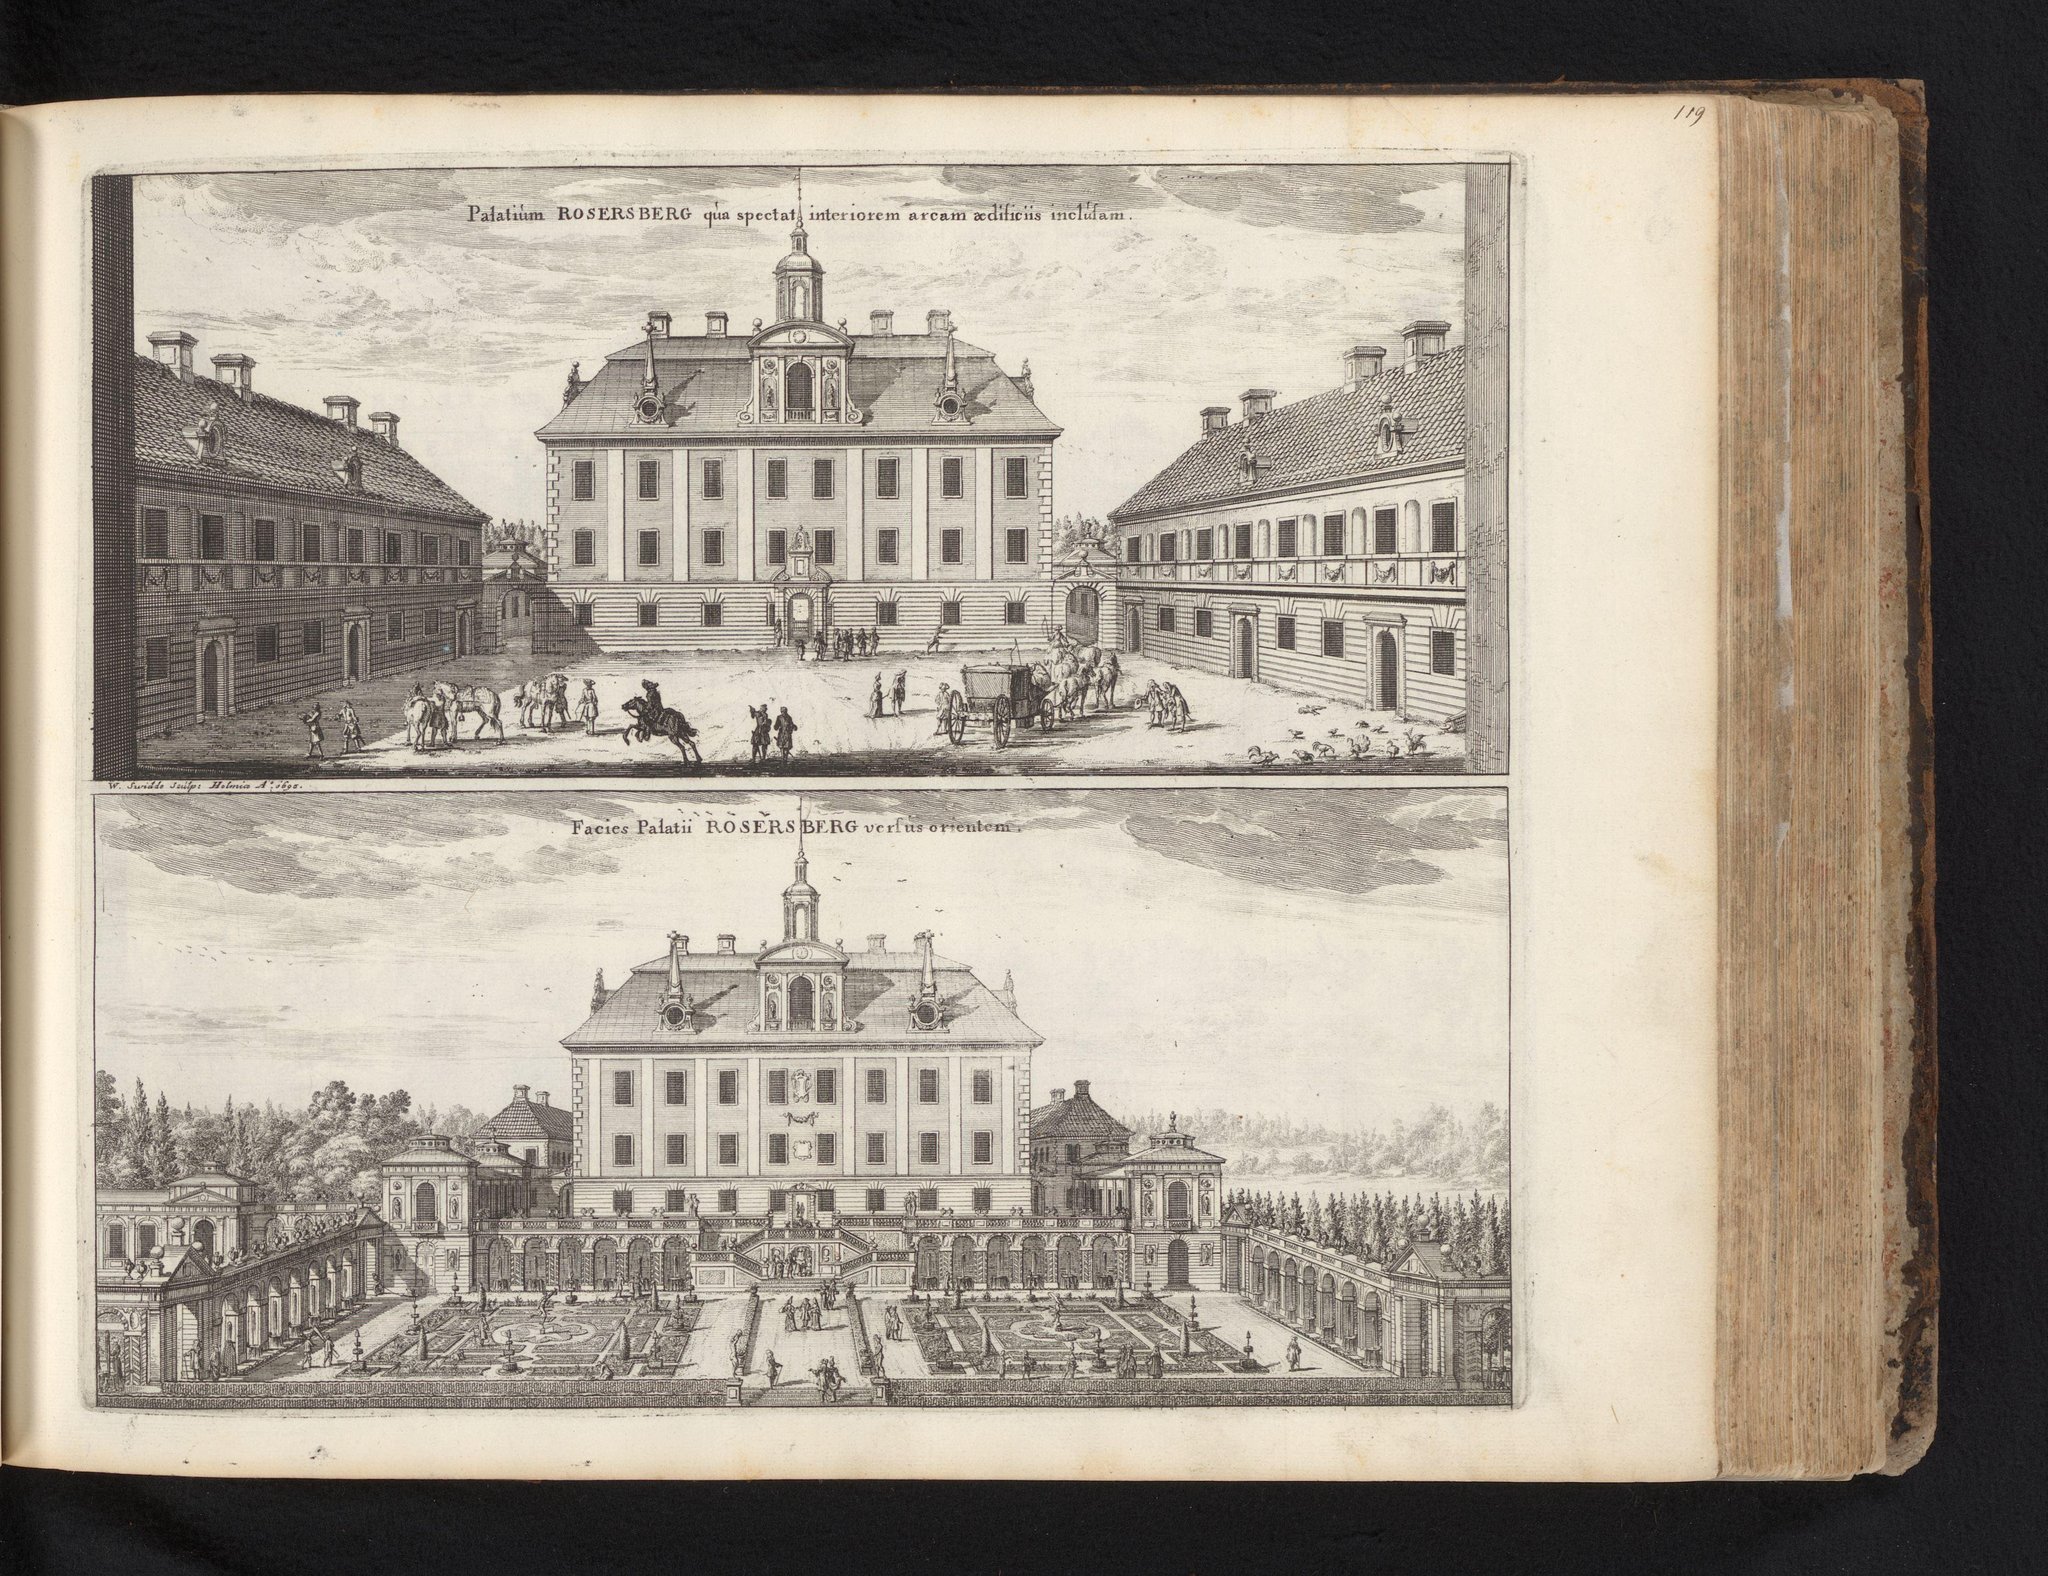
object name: album leaf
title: Suecia Antiqua et Hodierna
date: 1695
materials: paper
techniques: etching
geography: stockholm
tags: housing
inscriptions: date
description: Kungliga Biblioteket, 'Suecia': http://www.kb.se/samlingarna/Kartor-bilder/Suecia-antiqua/ (geraadpleegd november 2016).